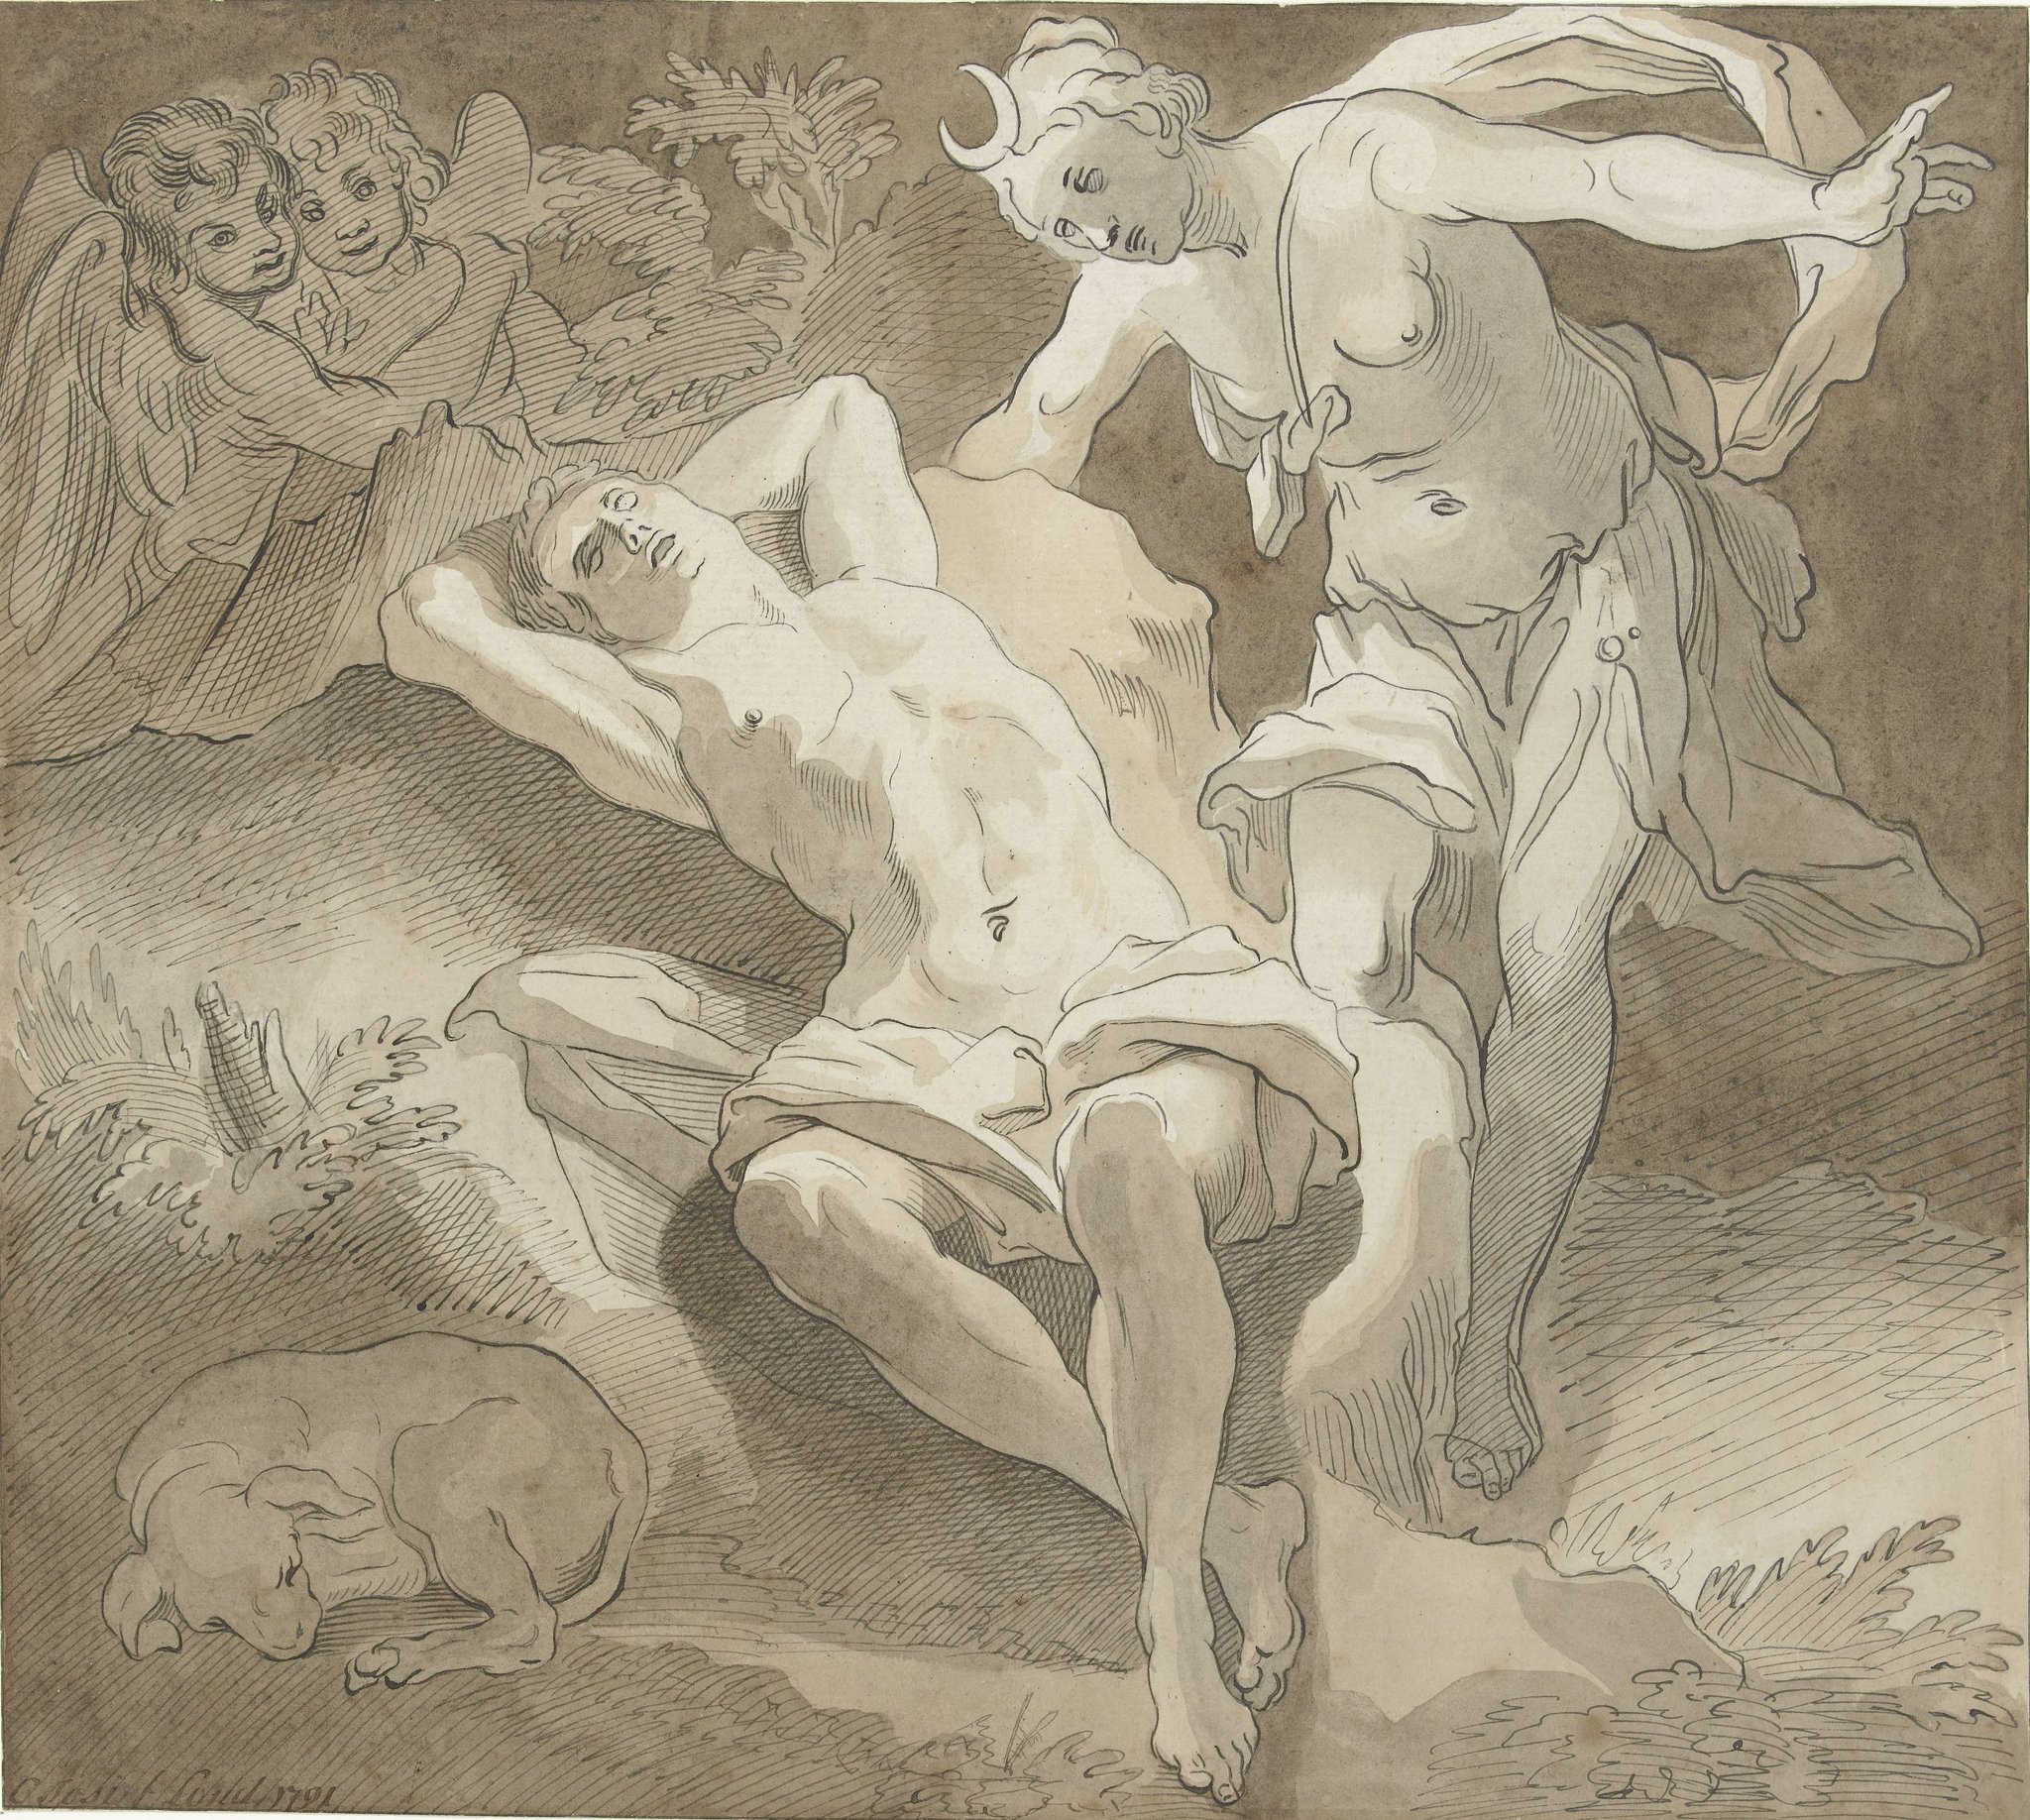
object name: drawing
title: Selene en Endymion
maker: christiaan josi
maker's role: draughtsman, print maker, publisher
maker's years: 1765-1828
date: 1791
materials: ink, paper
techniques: brush, pen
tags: diana (luna) visiting the sleeping endymion